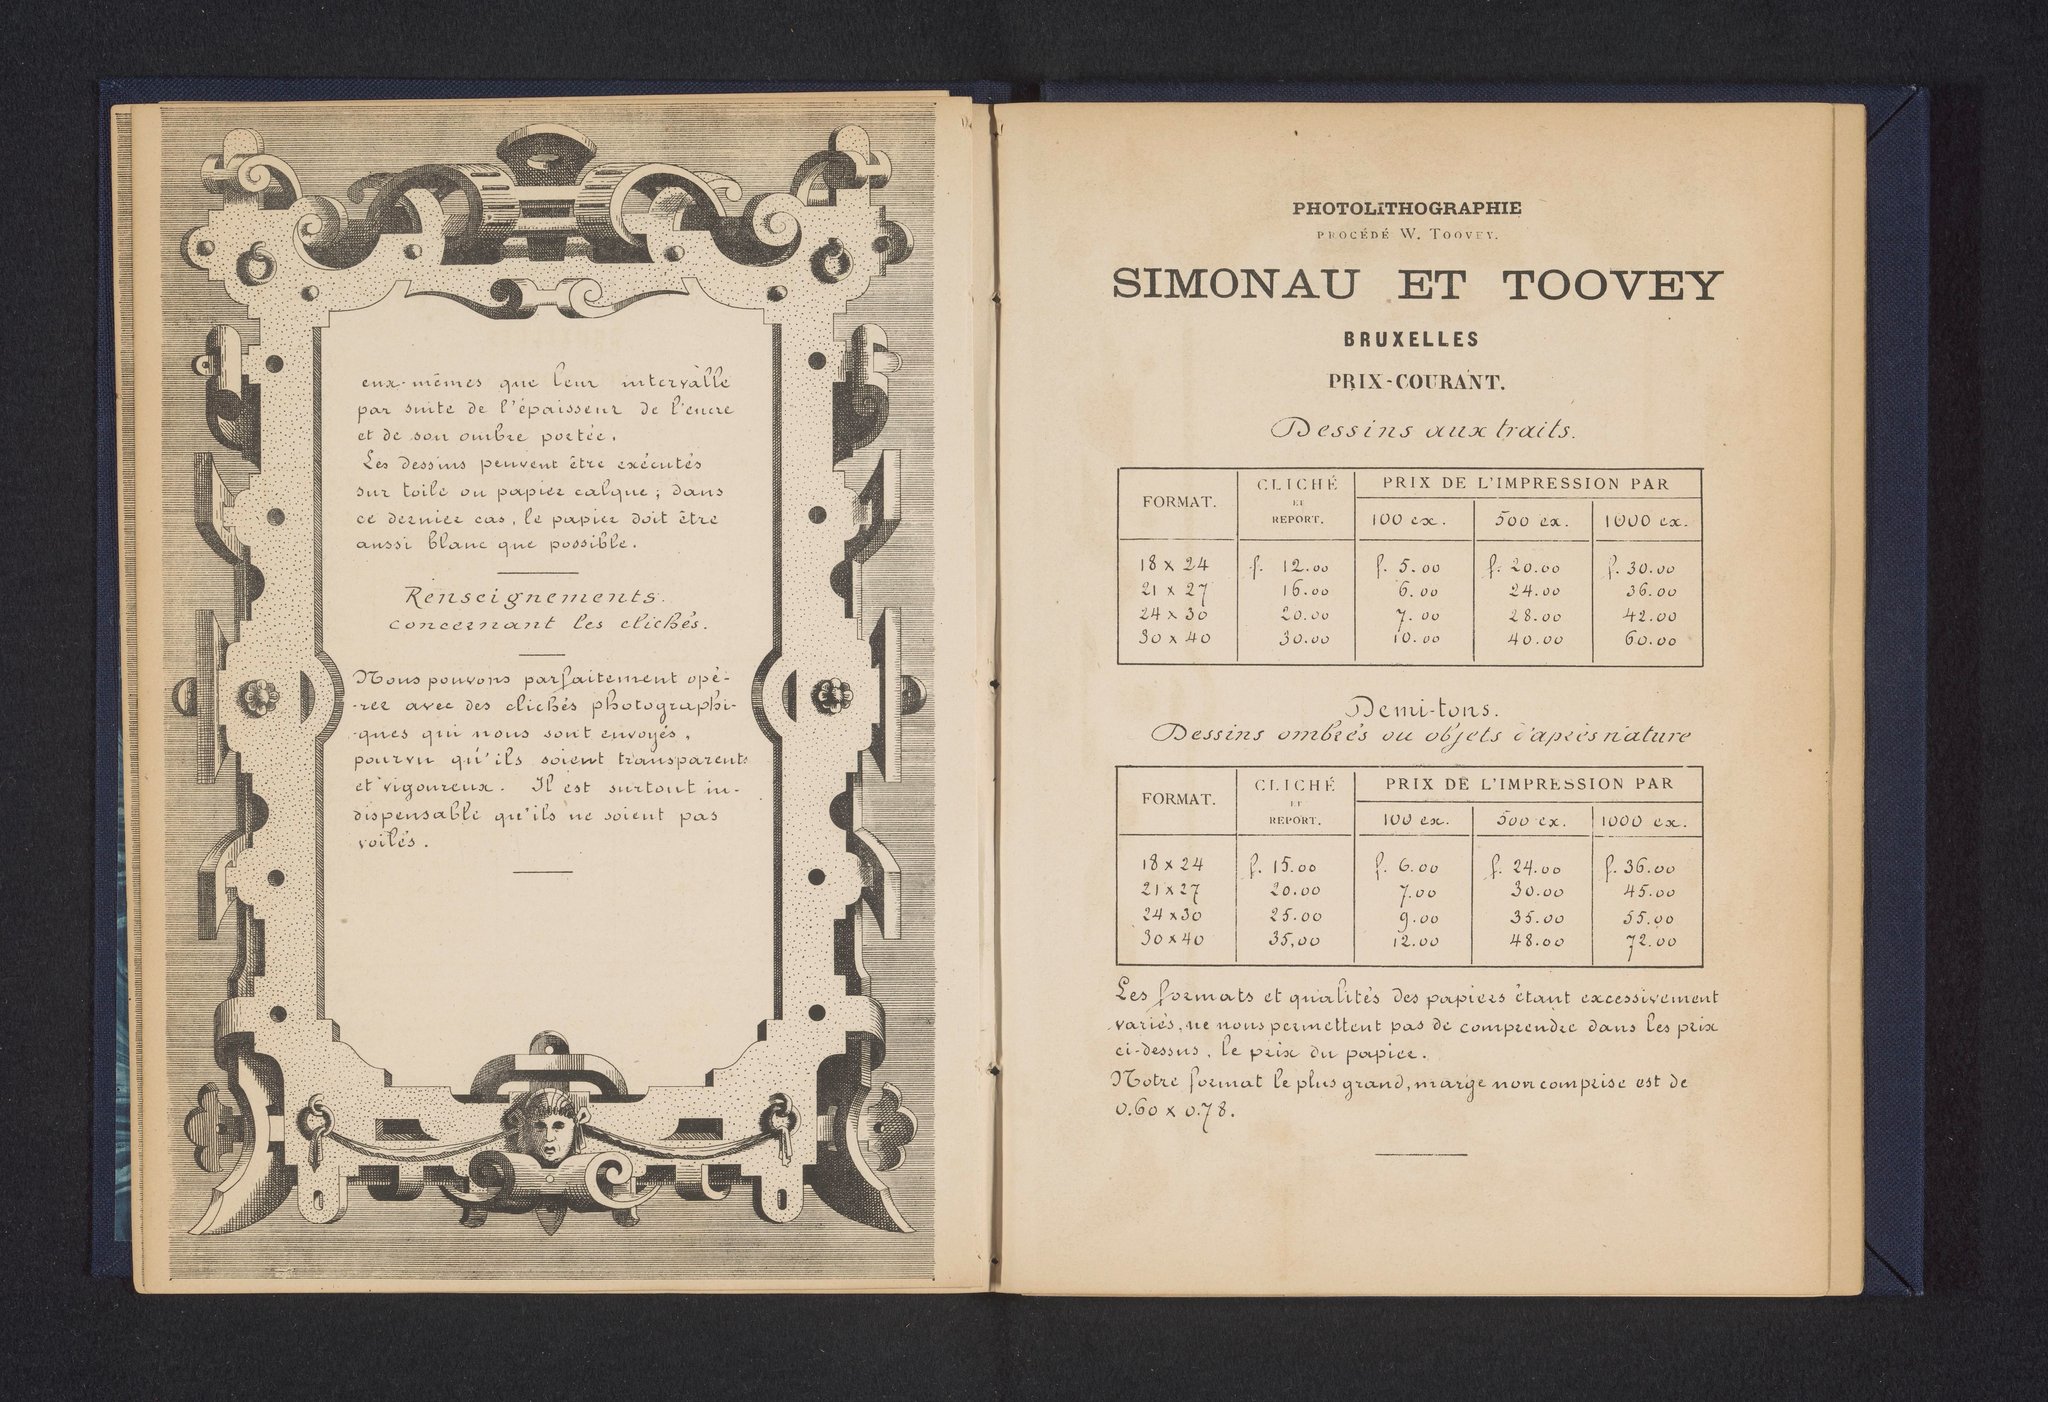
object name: fondslijst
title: prix courant uit Notice sur la photolithographie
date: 1873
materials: paper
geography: antwerp